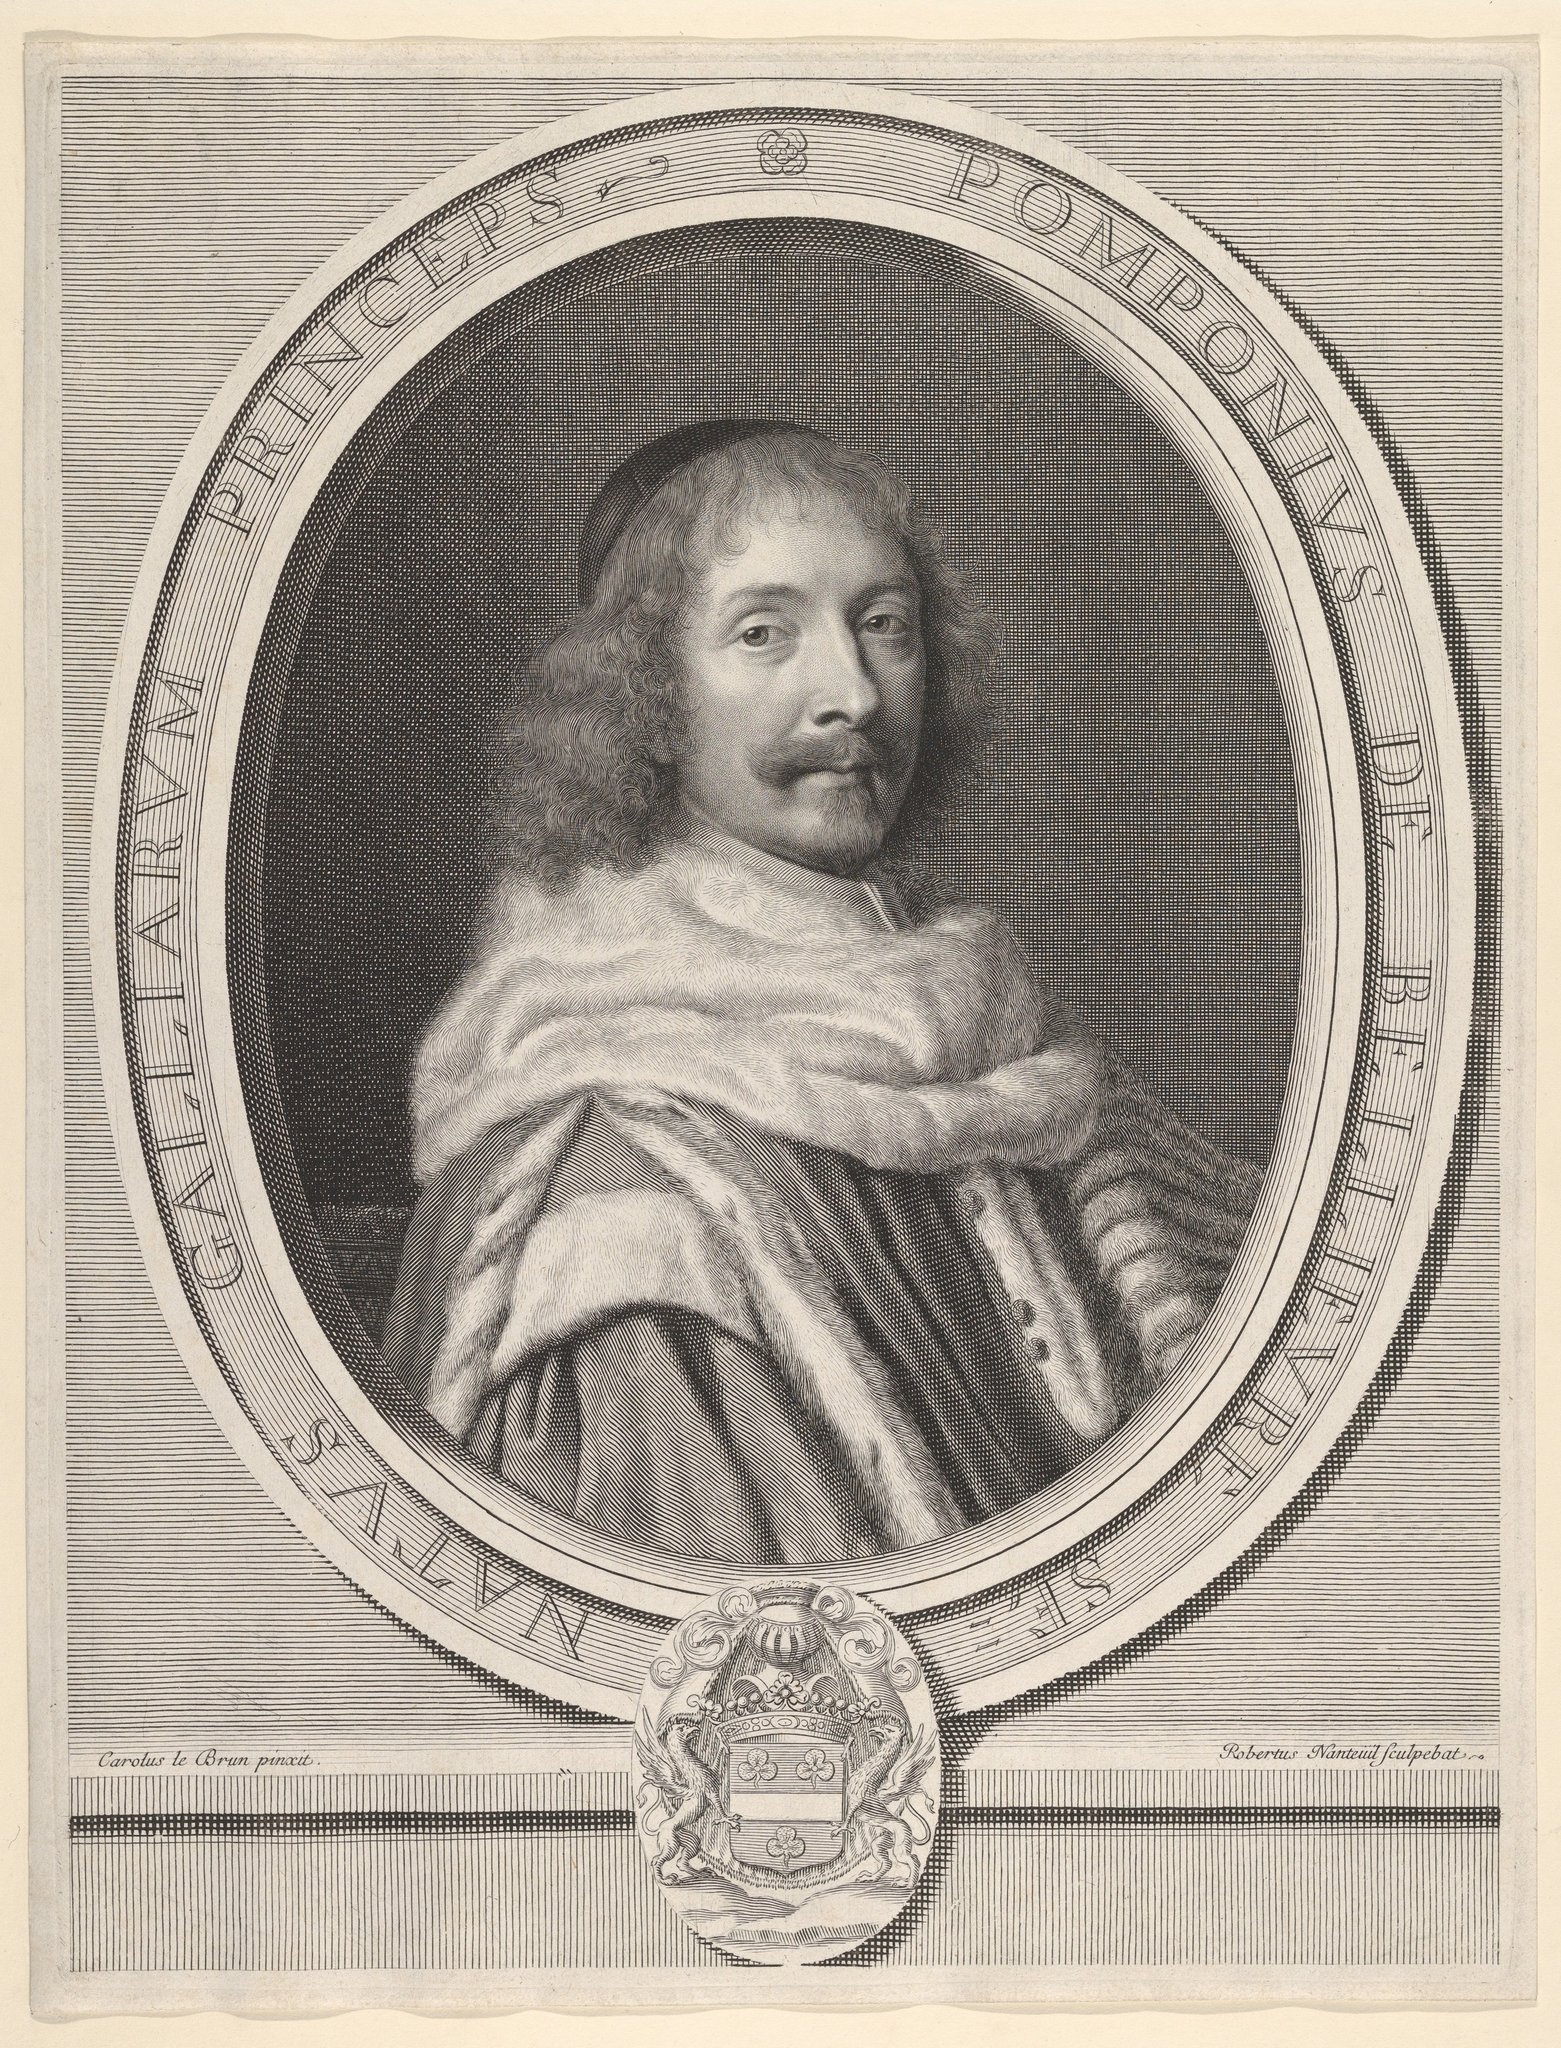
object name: print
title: Pompone II de Bellièvre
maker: robert nanteuil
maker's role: artist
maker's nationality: french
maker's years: 1623-1678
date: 1657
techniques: engraving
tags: men,portraits,coat of arms